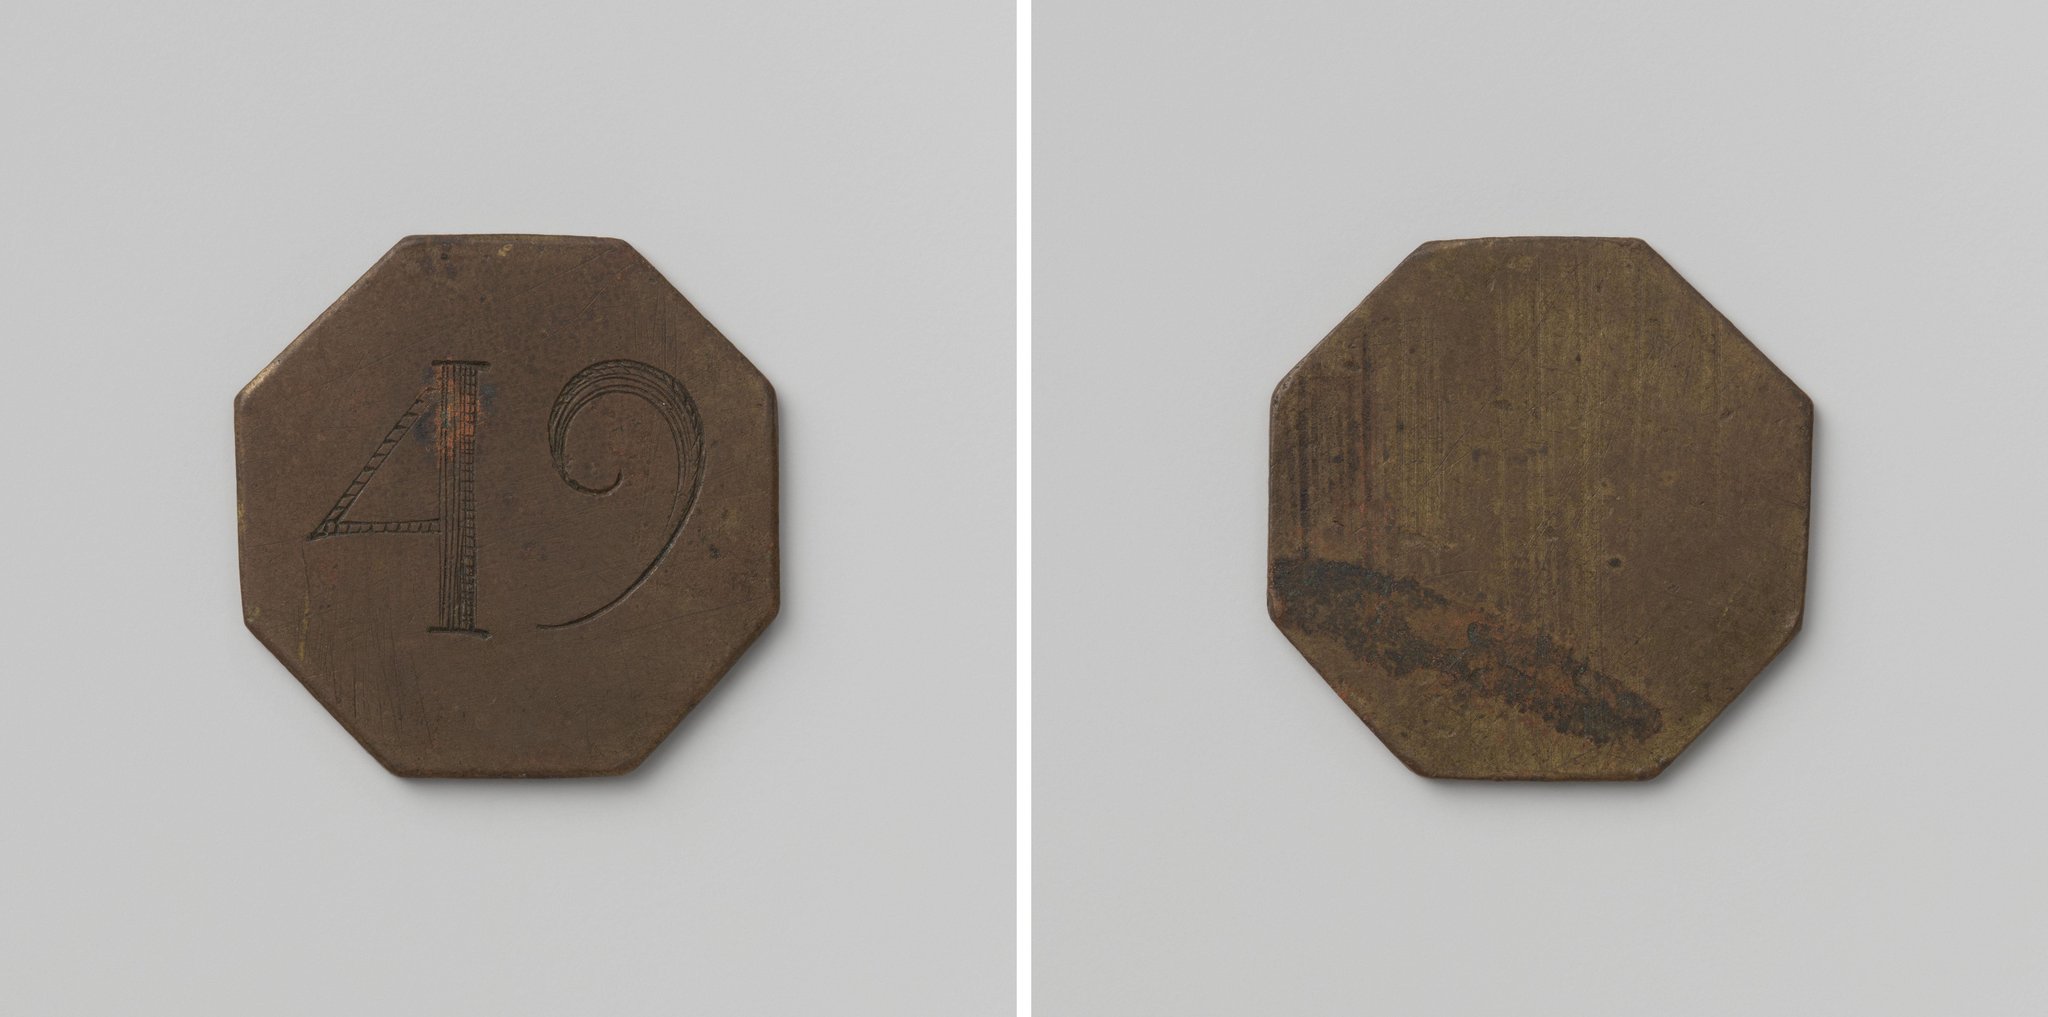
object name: lidmaatschapspenning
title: Onbekende plaats, lidmaatschapspenning met no. 49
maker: Anonymous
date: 1650-1750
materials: brass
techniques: engraving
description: Eenzijdige messing achthoekige penning. Voorzijde: cijfer 49. Keerzijde: blanco